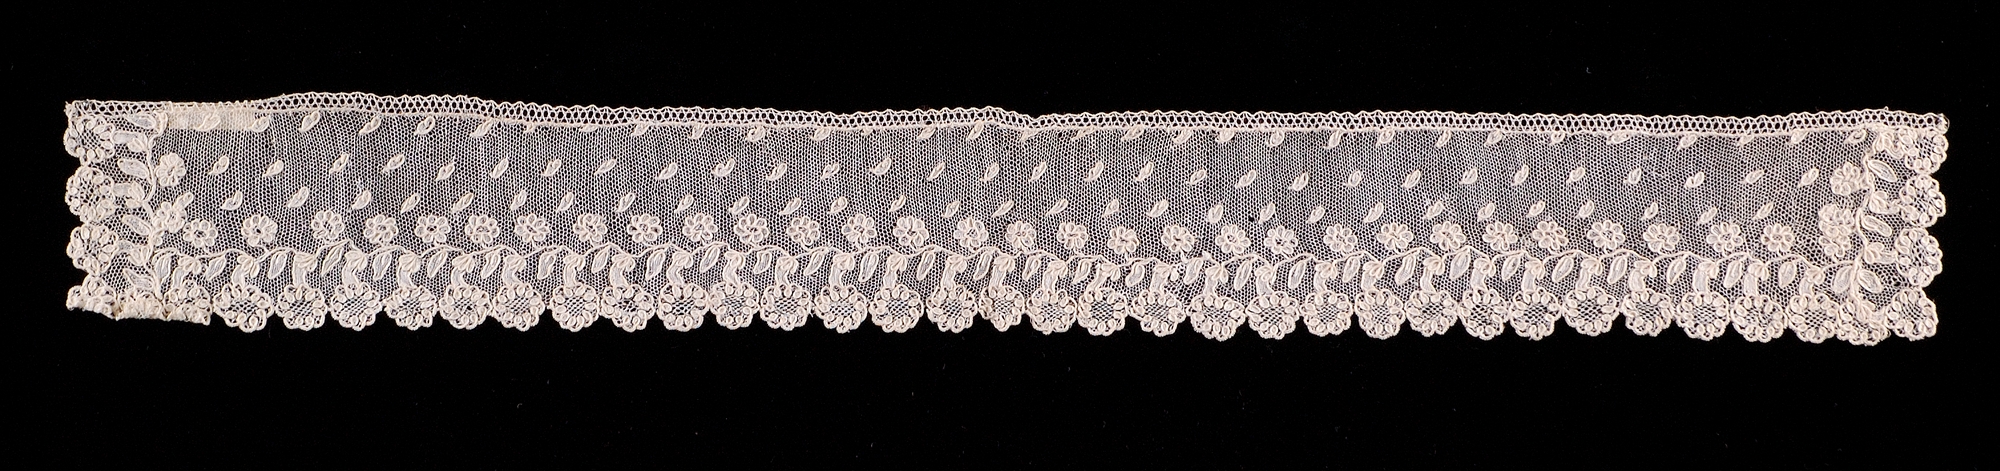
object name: collar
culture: french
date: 1860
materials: linen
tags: flowers